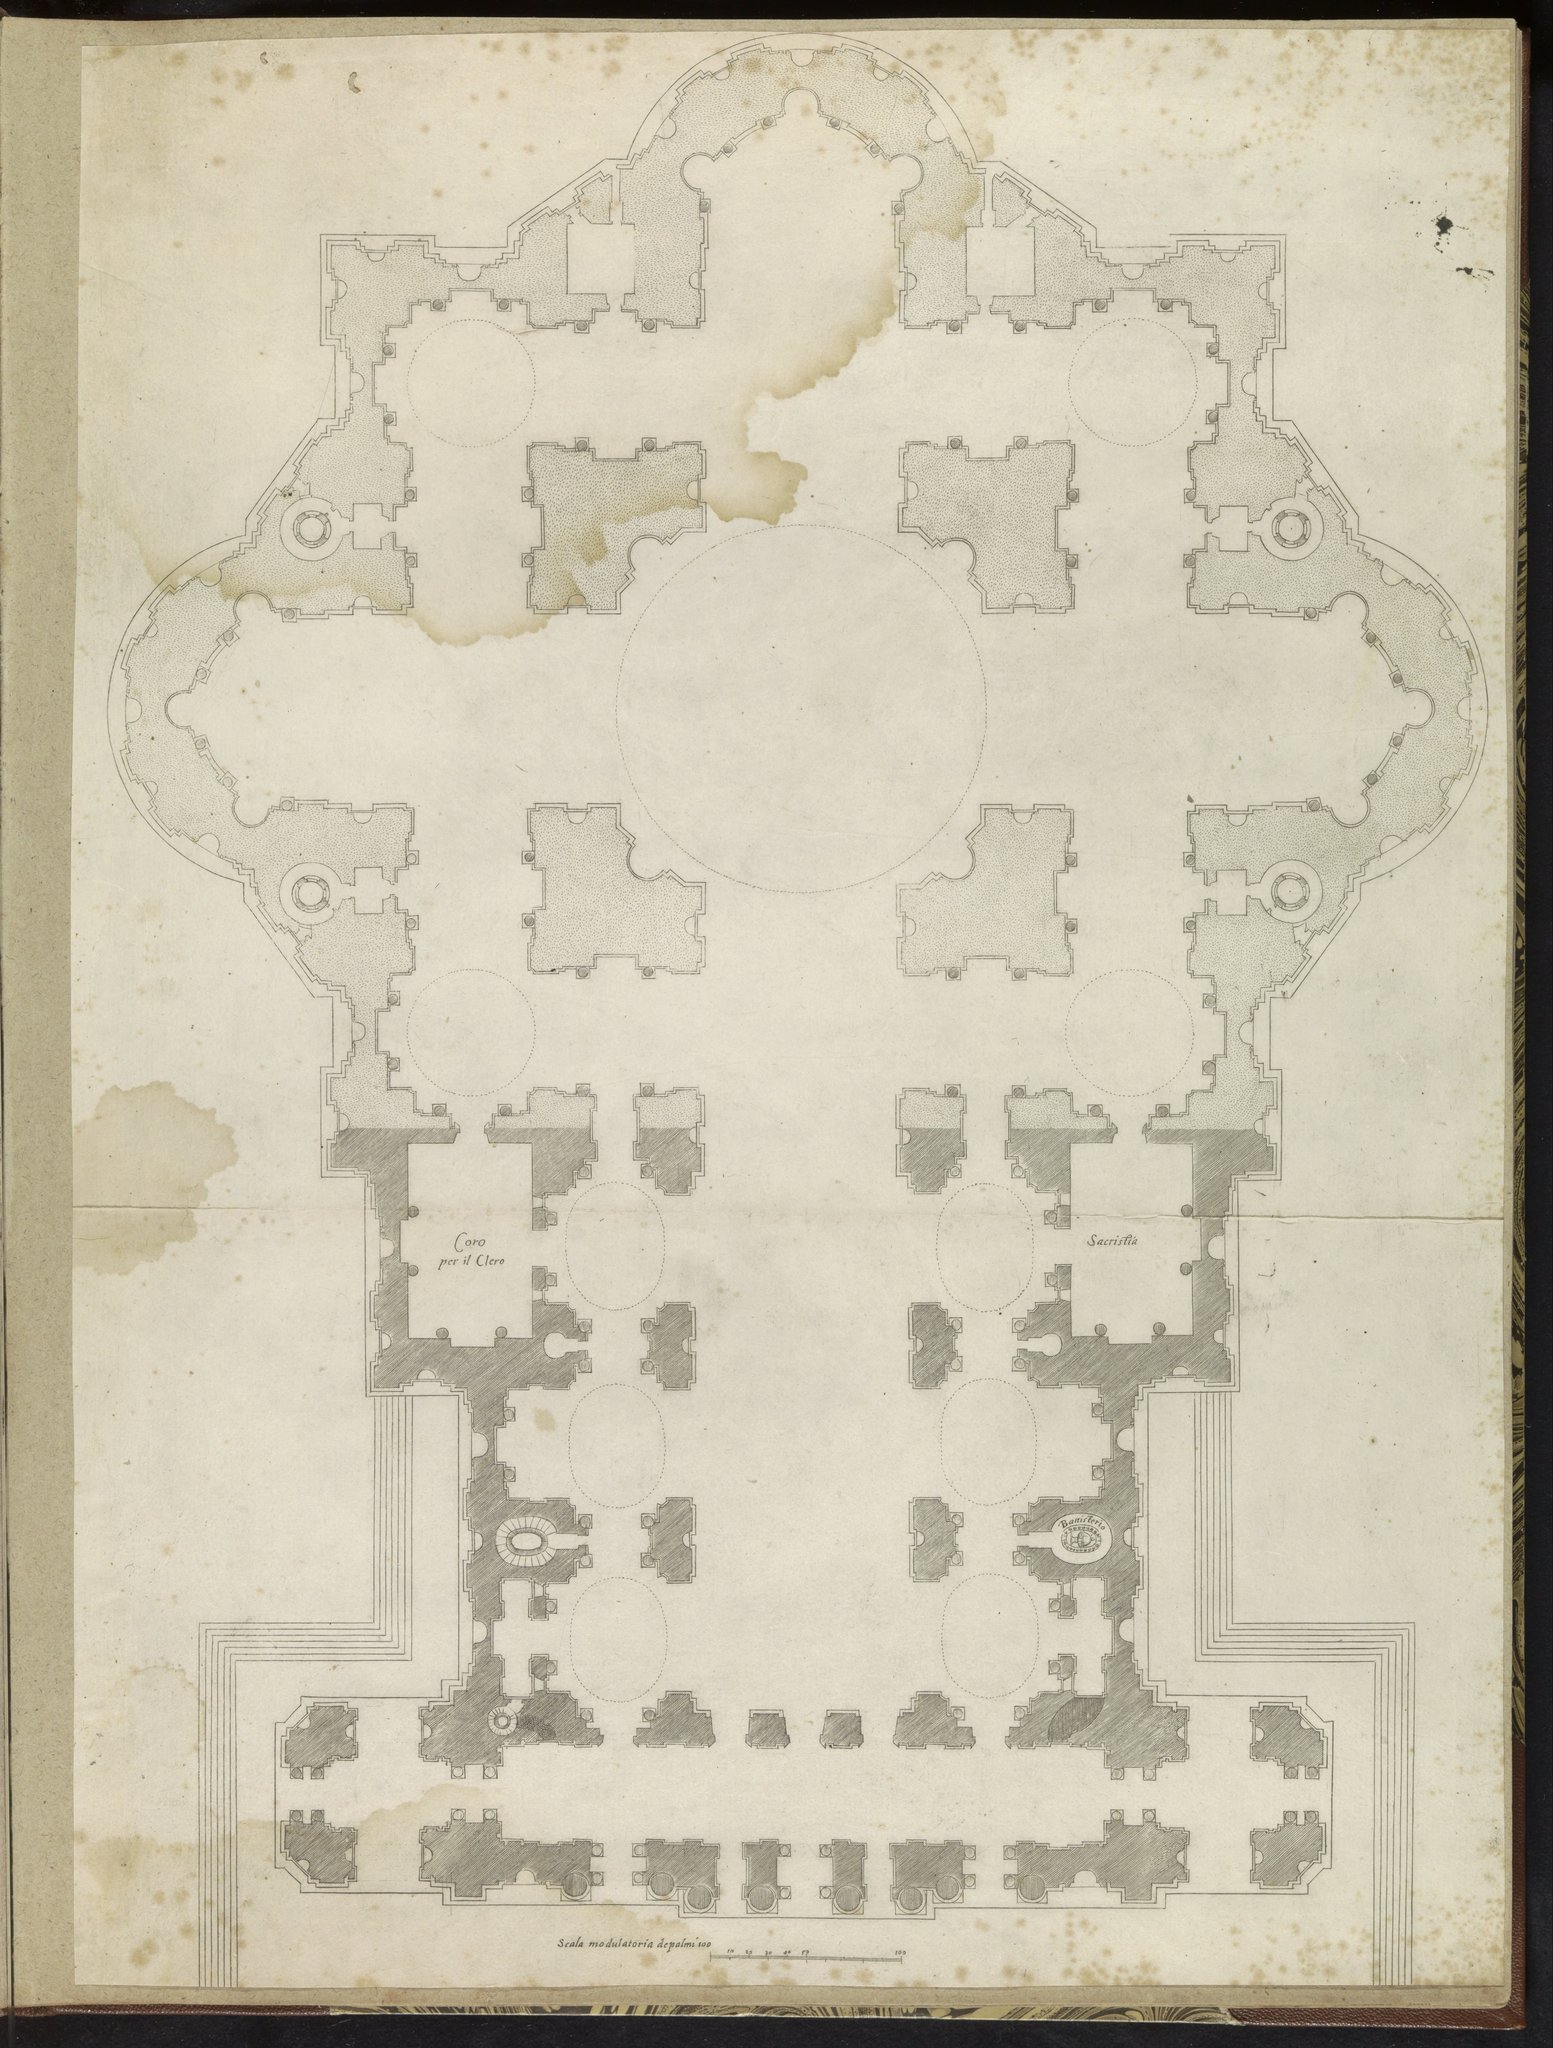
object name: print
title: Plattegrond van de Sint-Pietersbasiliek te Vaticaanstad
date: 1637-1691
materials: paper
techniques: engraving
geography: rome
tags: roman catholic church, plan ~ architecture